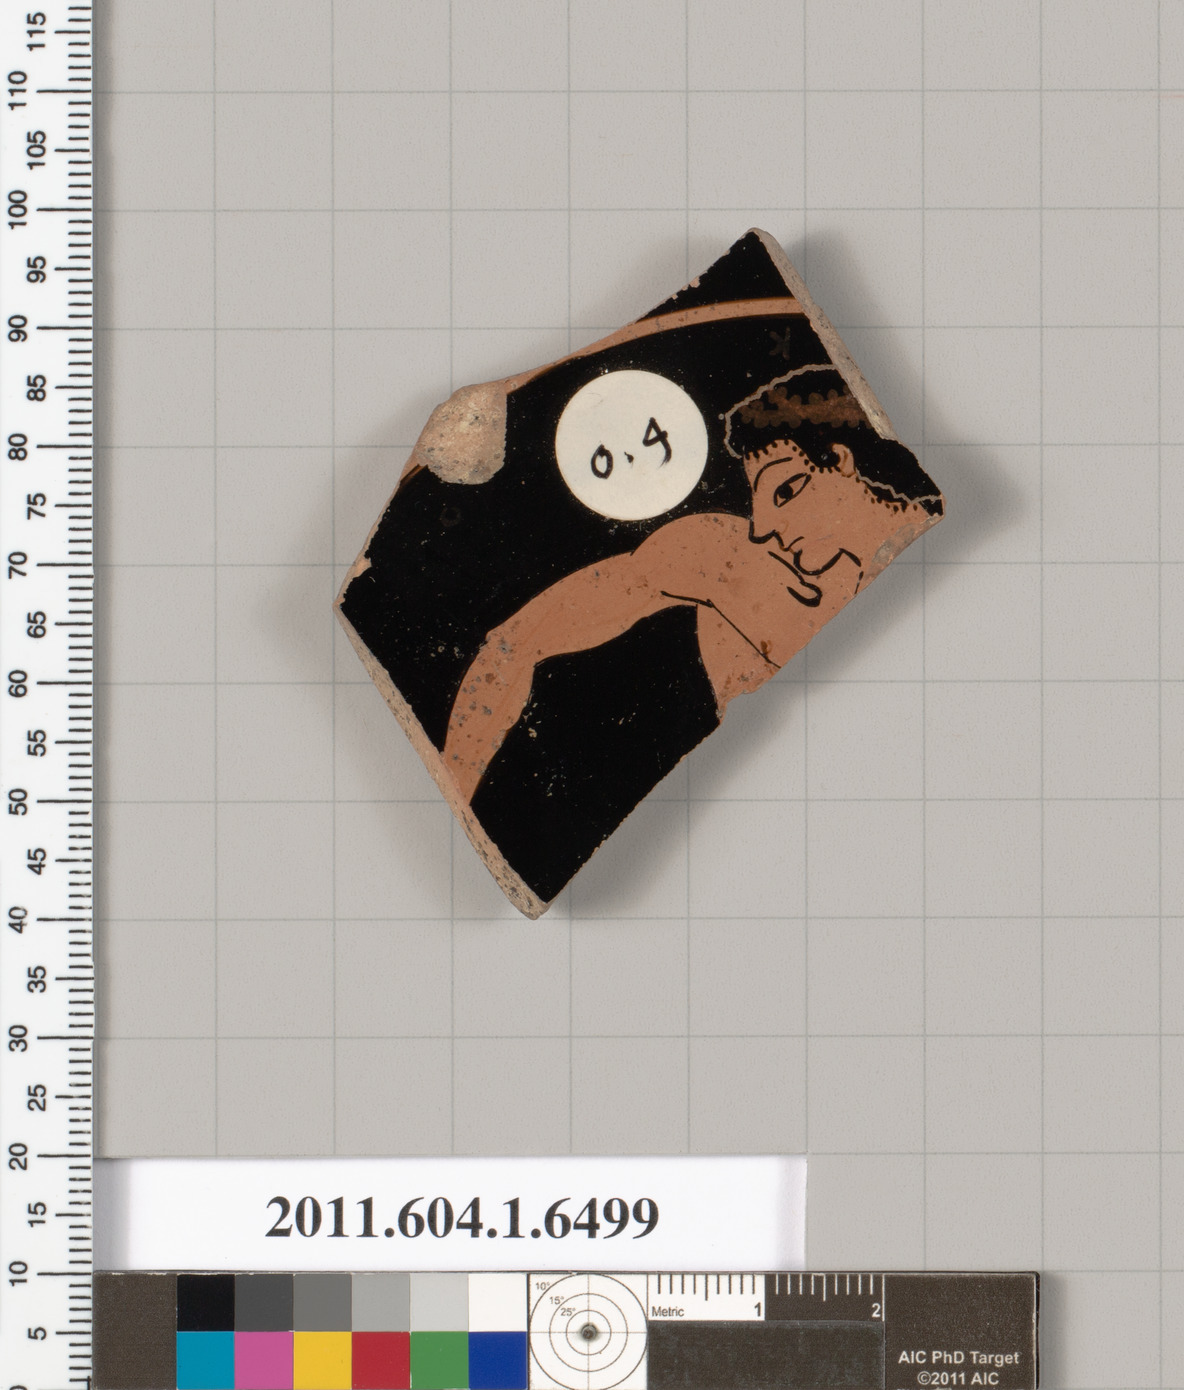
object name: kylix fragment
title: Terracotta fragment of a kylix (drinking cup)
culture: greek, attic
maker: colmar painter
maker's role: artist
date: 490-480 BCE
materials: terracotta